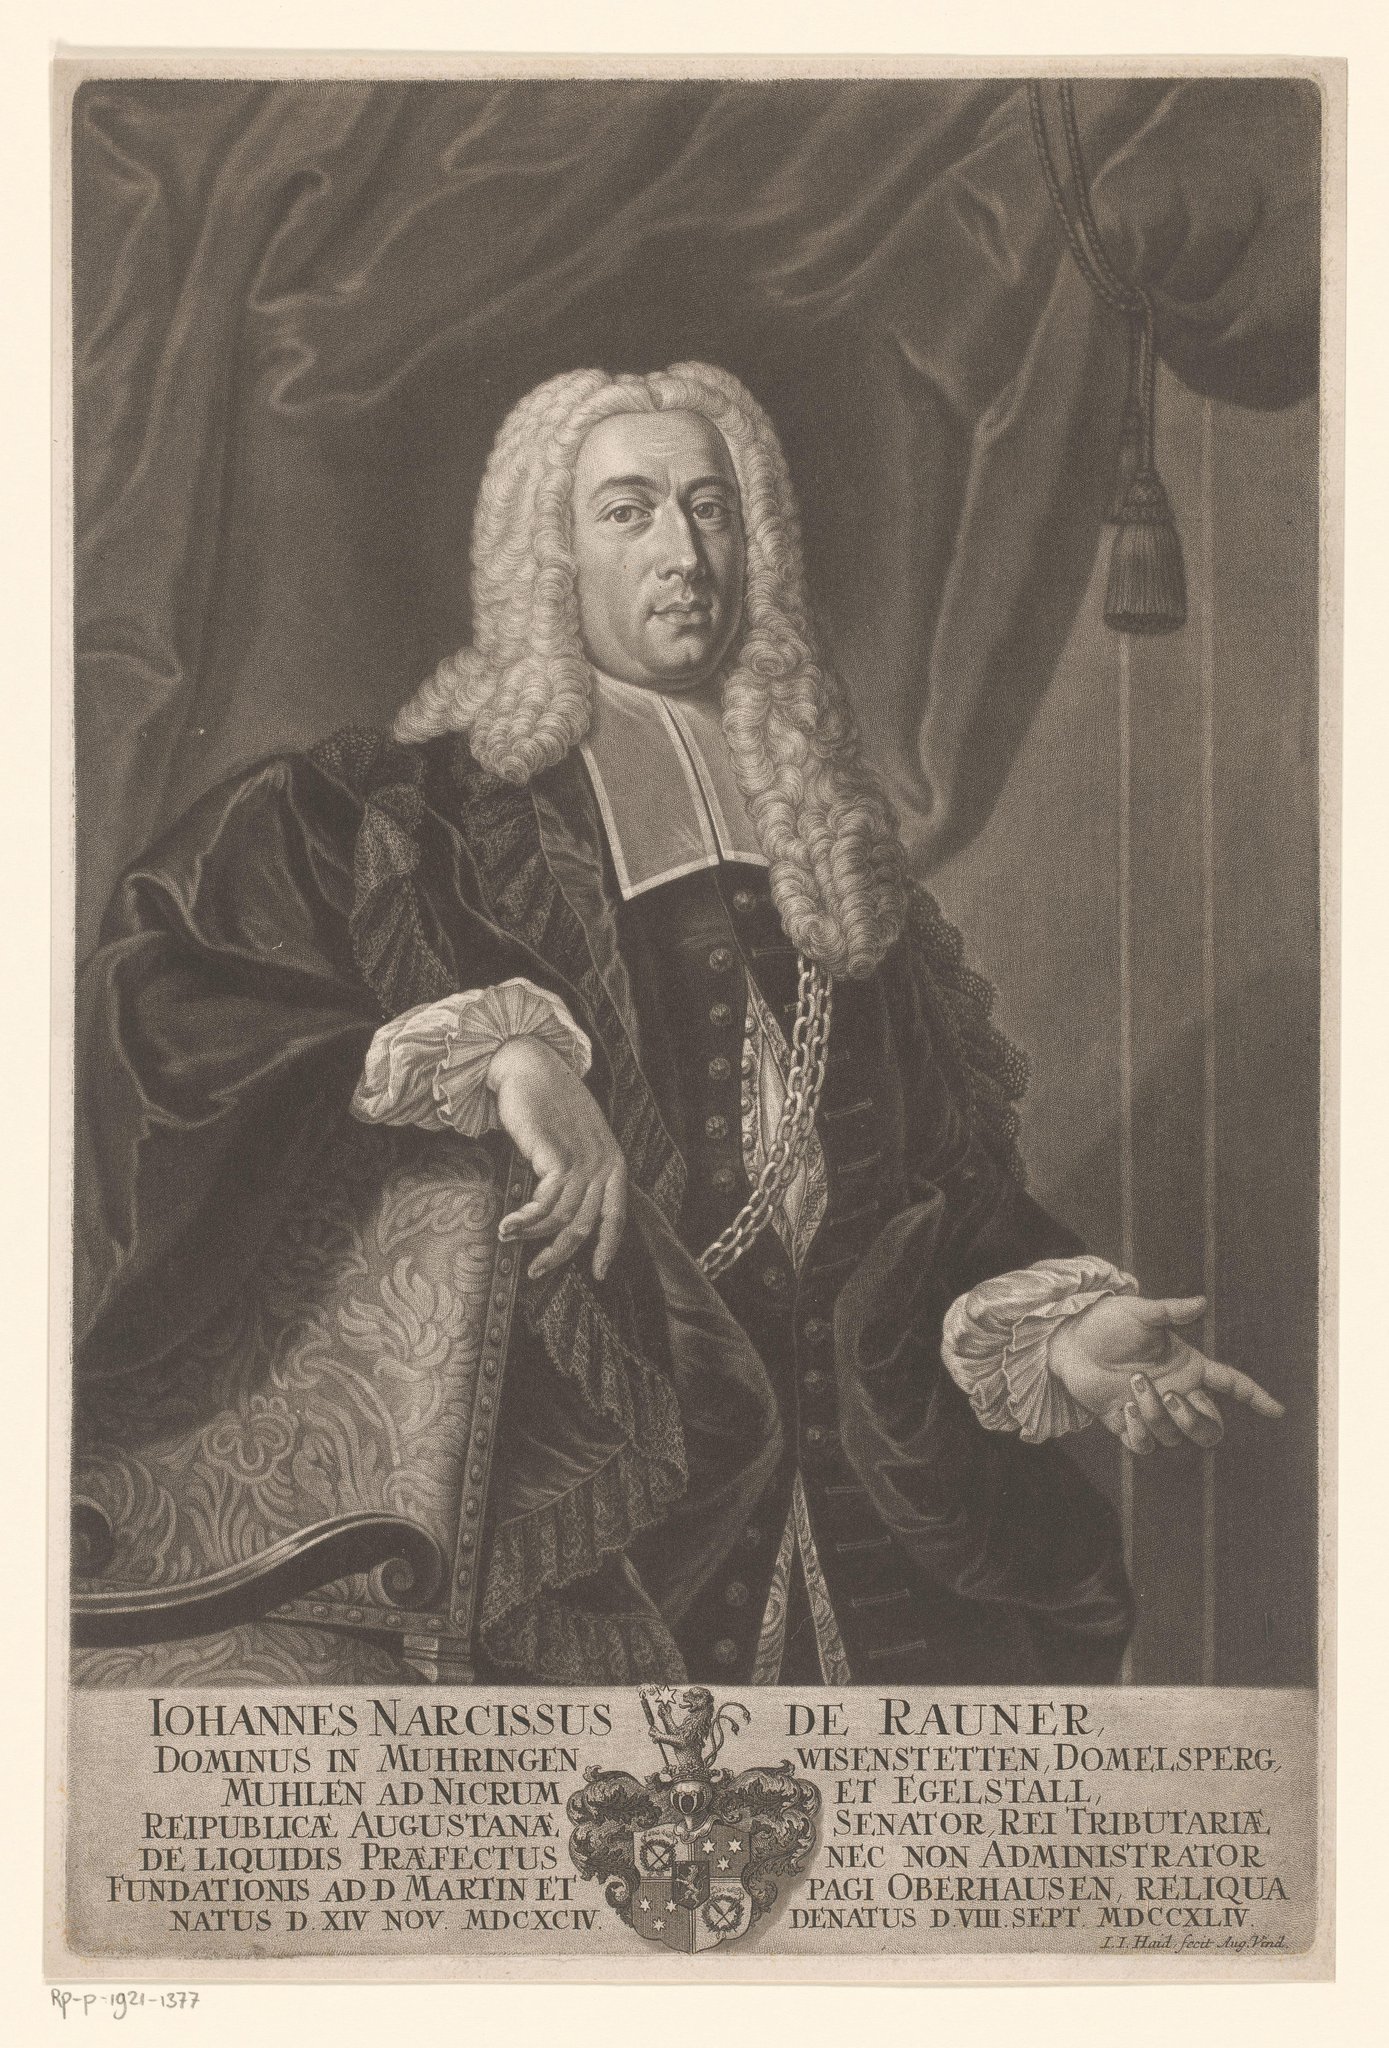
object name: print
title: Portret van Johann Narcissus Rauner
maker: johann jacob haid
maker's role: print maker, publisher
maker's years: 1704-1767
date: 1744-1767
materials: paper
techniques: etching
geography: augsburg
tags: historical persons, armorial bearing, heraldry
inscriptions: collector's mark: Lugt 2233